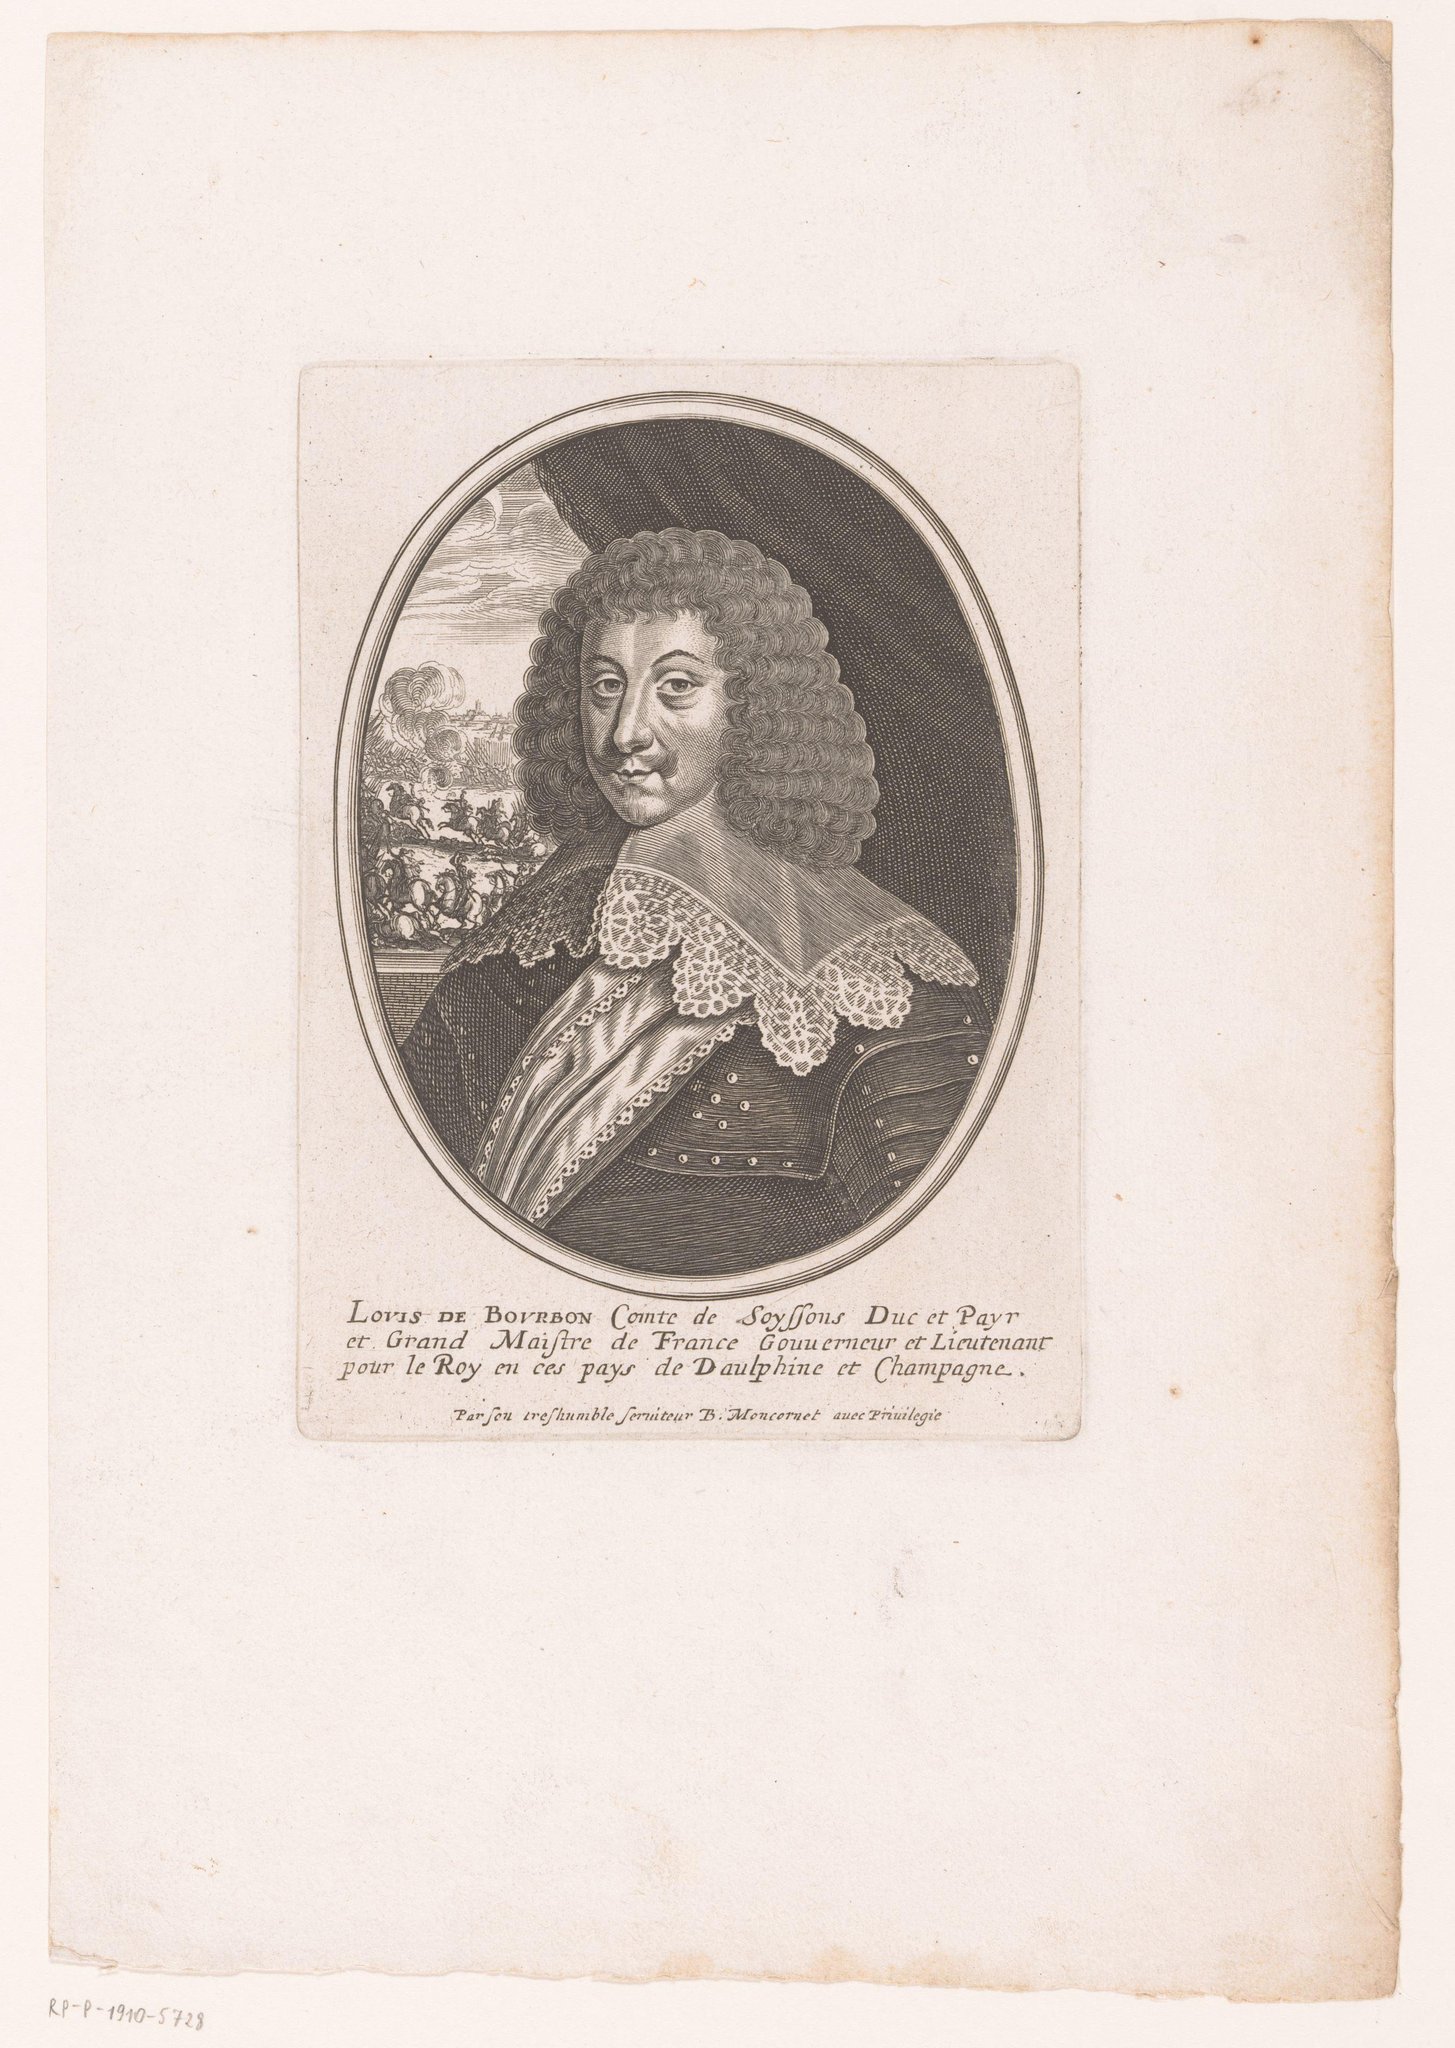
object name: print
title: Portret van Lodewijk van Bourbon-Soissons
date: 1624-1668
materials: paper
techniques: engraving, etching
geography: paris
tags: historical persons, nobility and patriciate; chivalry, knighthood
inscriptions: collector's mark: Lugt 2228